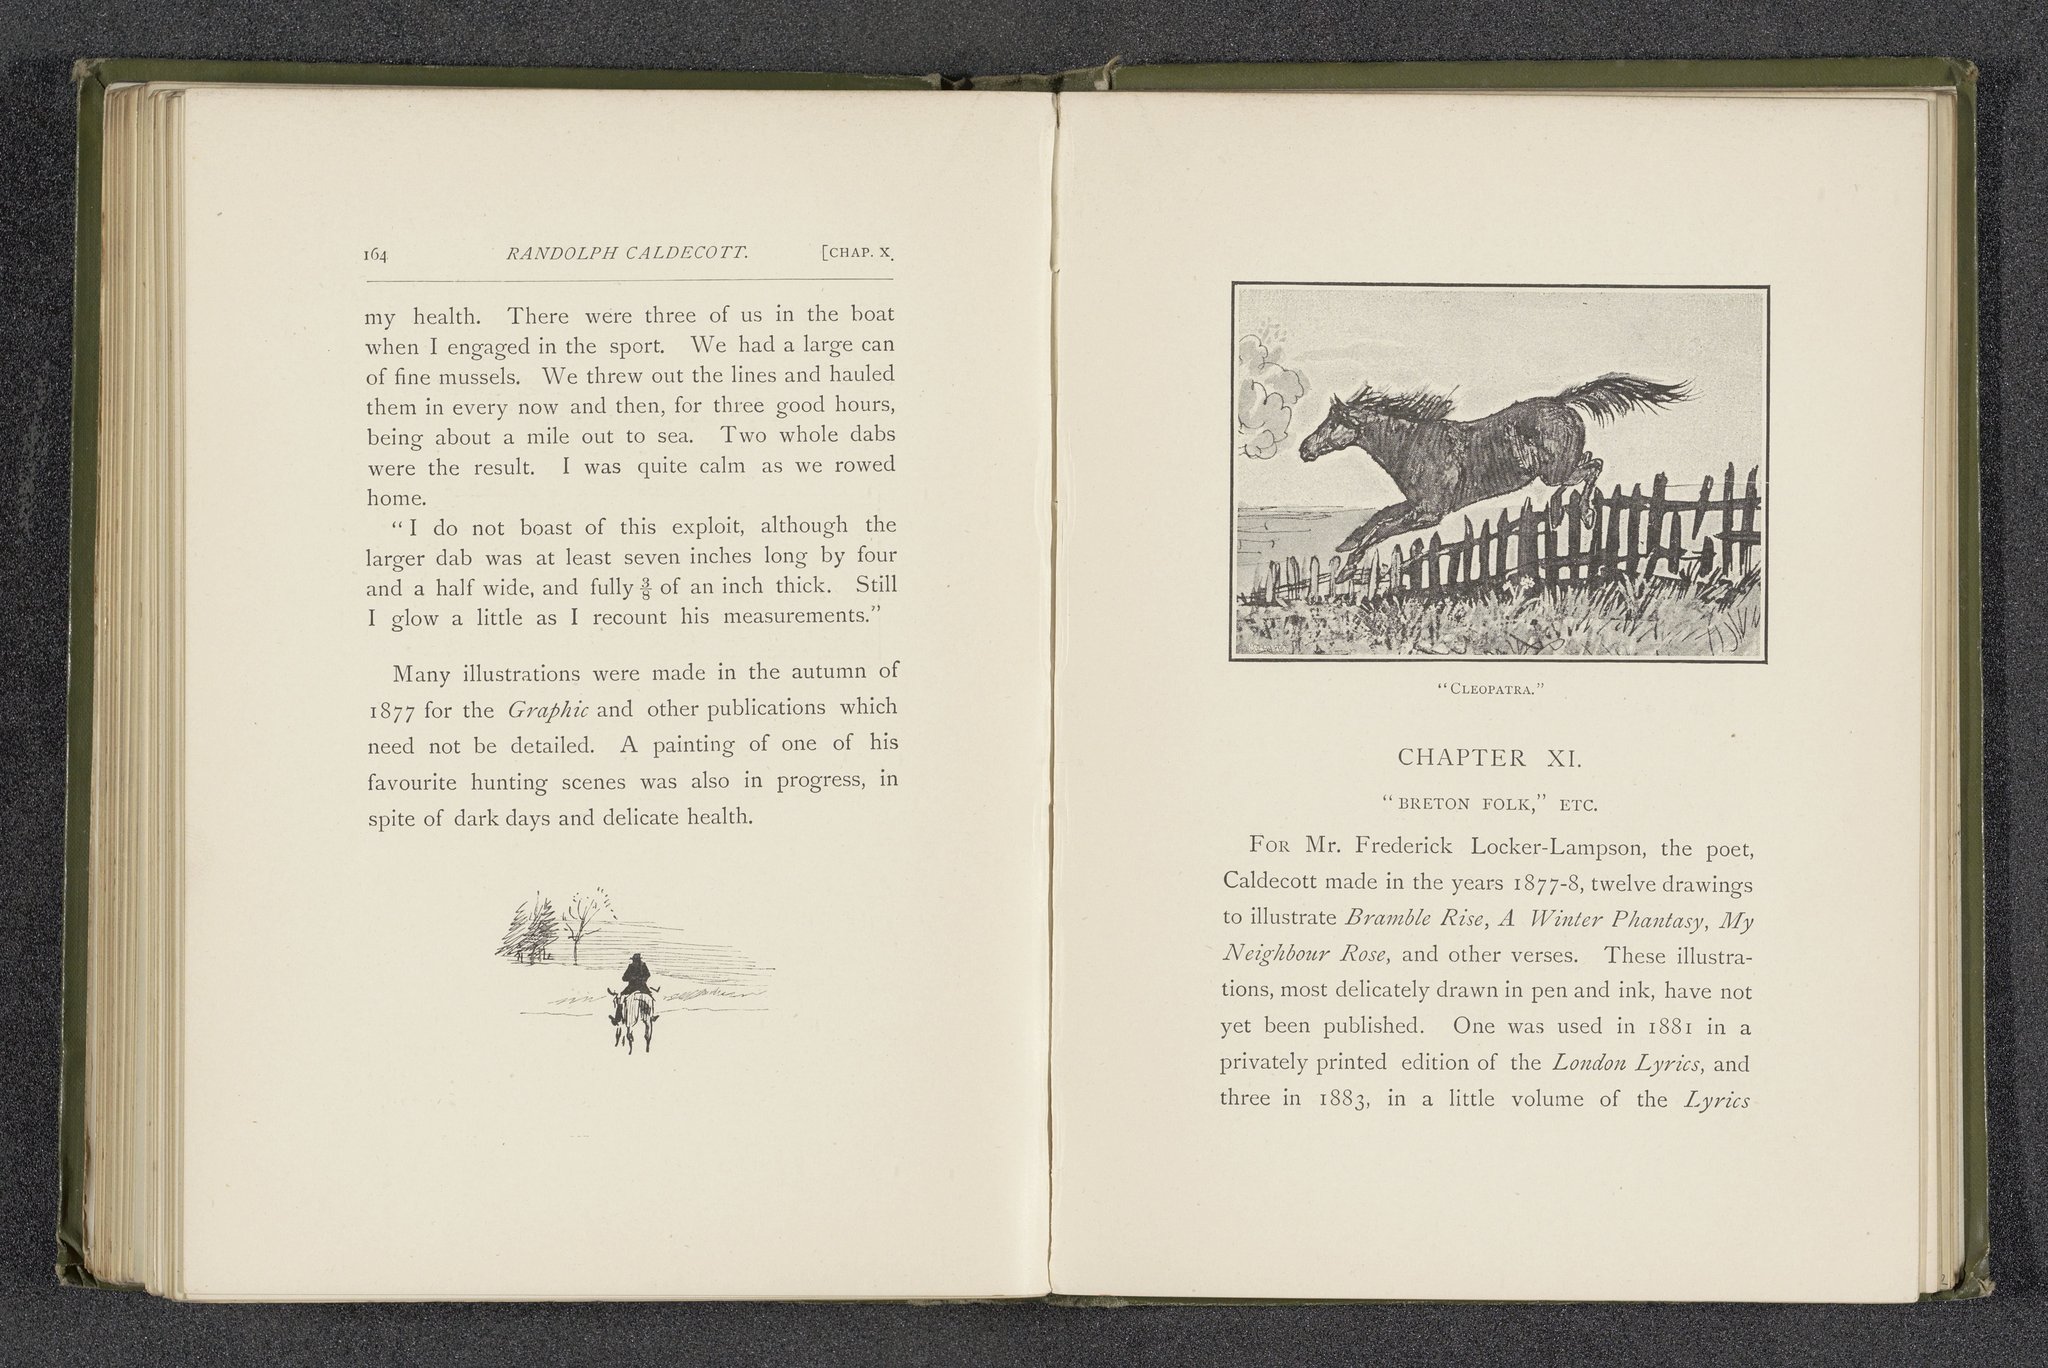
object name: page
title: Fotoreproductie van een tekening van een springend paard door Randolph Caldecott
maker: Anonymous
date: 1877-1887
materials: paper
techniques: autotype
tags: drawing, sketch, horse